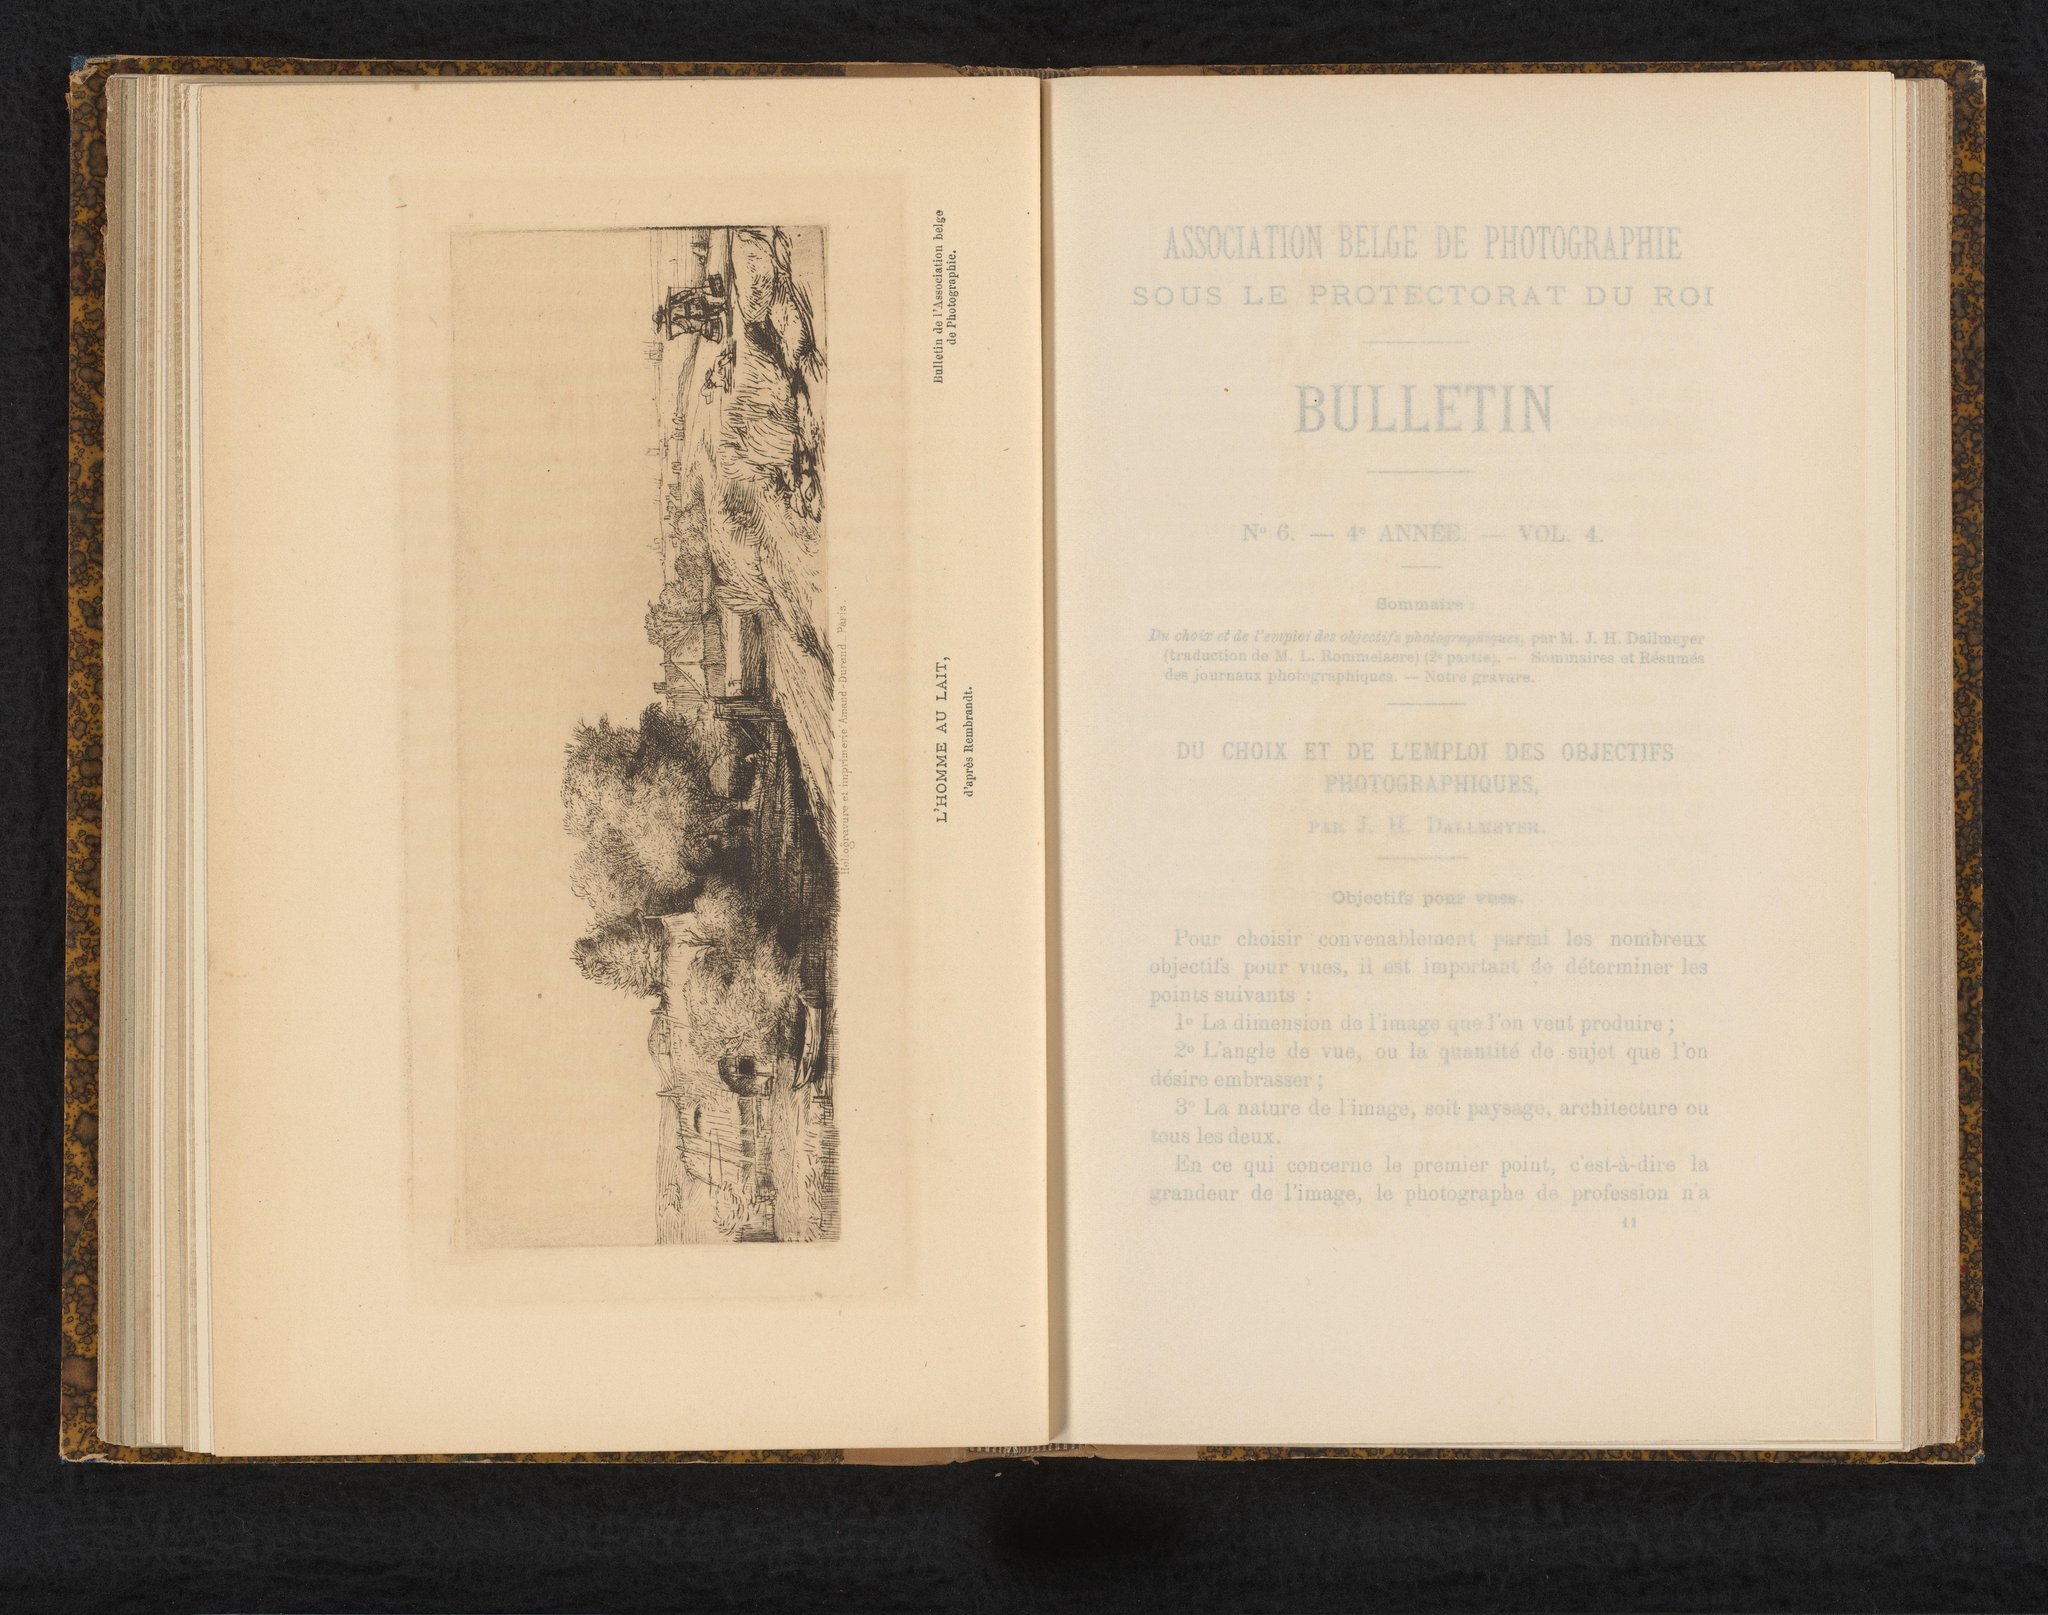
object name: reproduction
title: L'homme au lait, d'après Rembrandt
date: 1877-1878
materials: paper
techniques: photoaquatint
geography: paris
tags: dikes, levee, carrying something with yoke, farm (building)